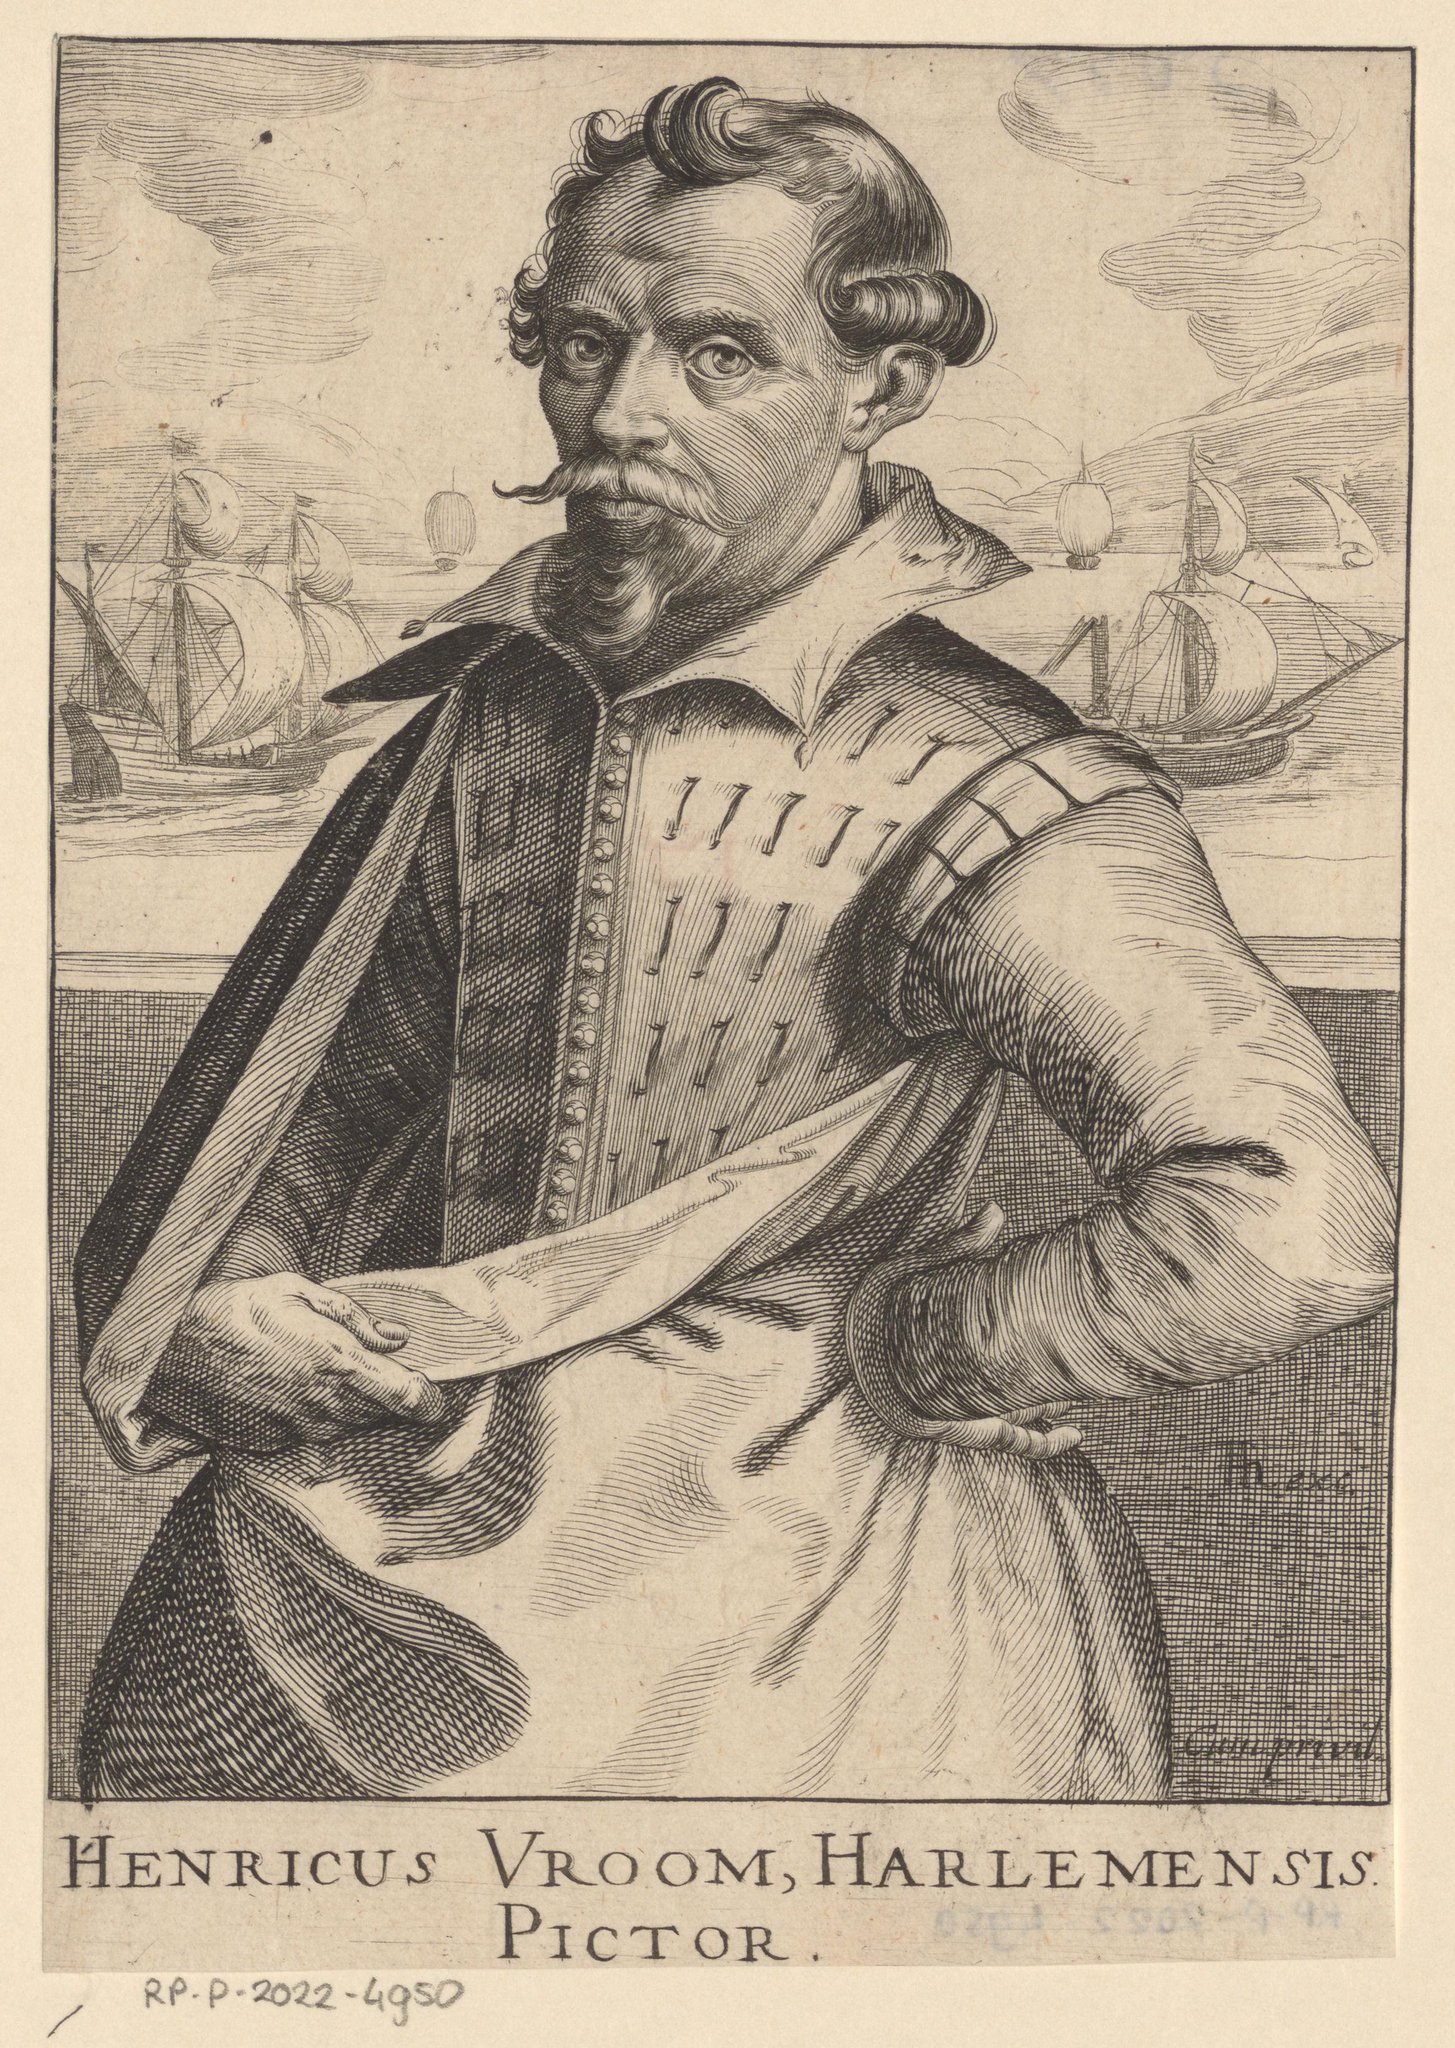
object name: print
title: Pictorum aliquot celebrium praecipuae Germaniae Inferioris effigies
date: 1610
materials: paper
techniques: etching, letterpress printing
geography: northern netherlands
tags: draughtsman, hendrick cornelisz vroom, historical persons, portrait, self-portrait of painter, portrait, self-portrait of graphic artist